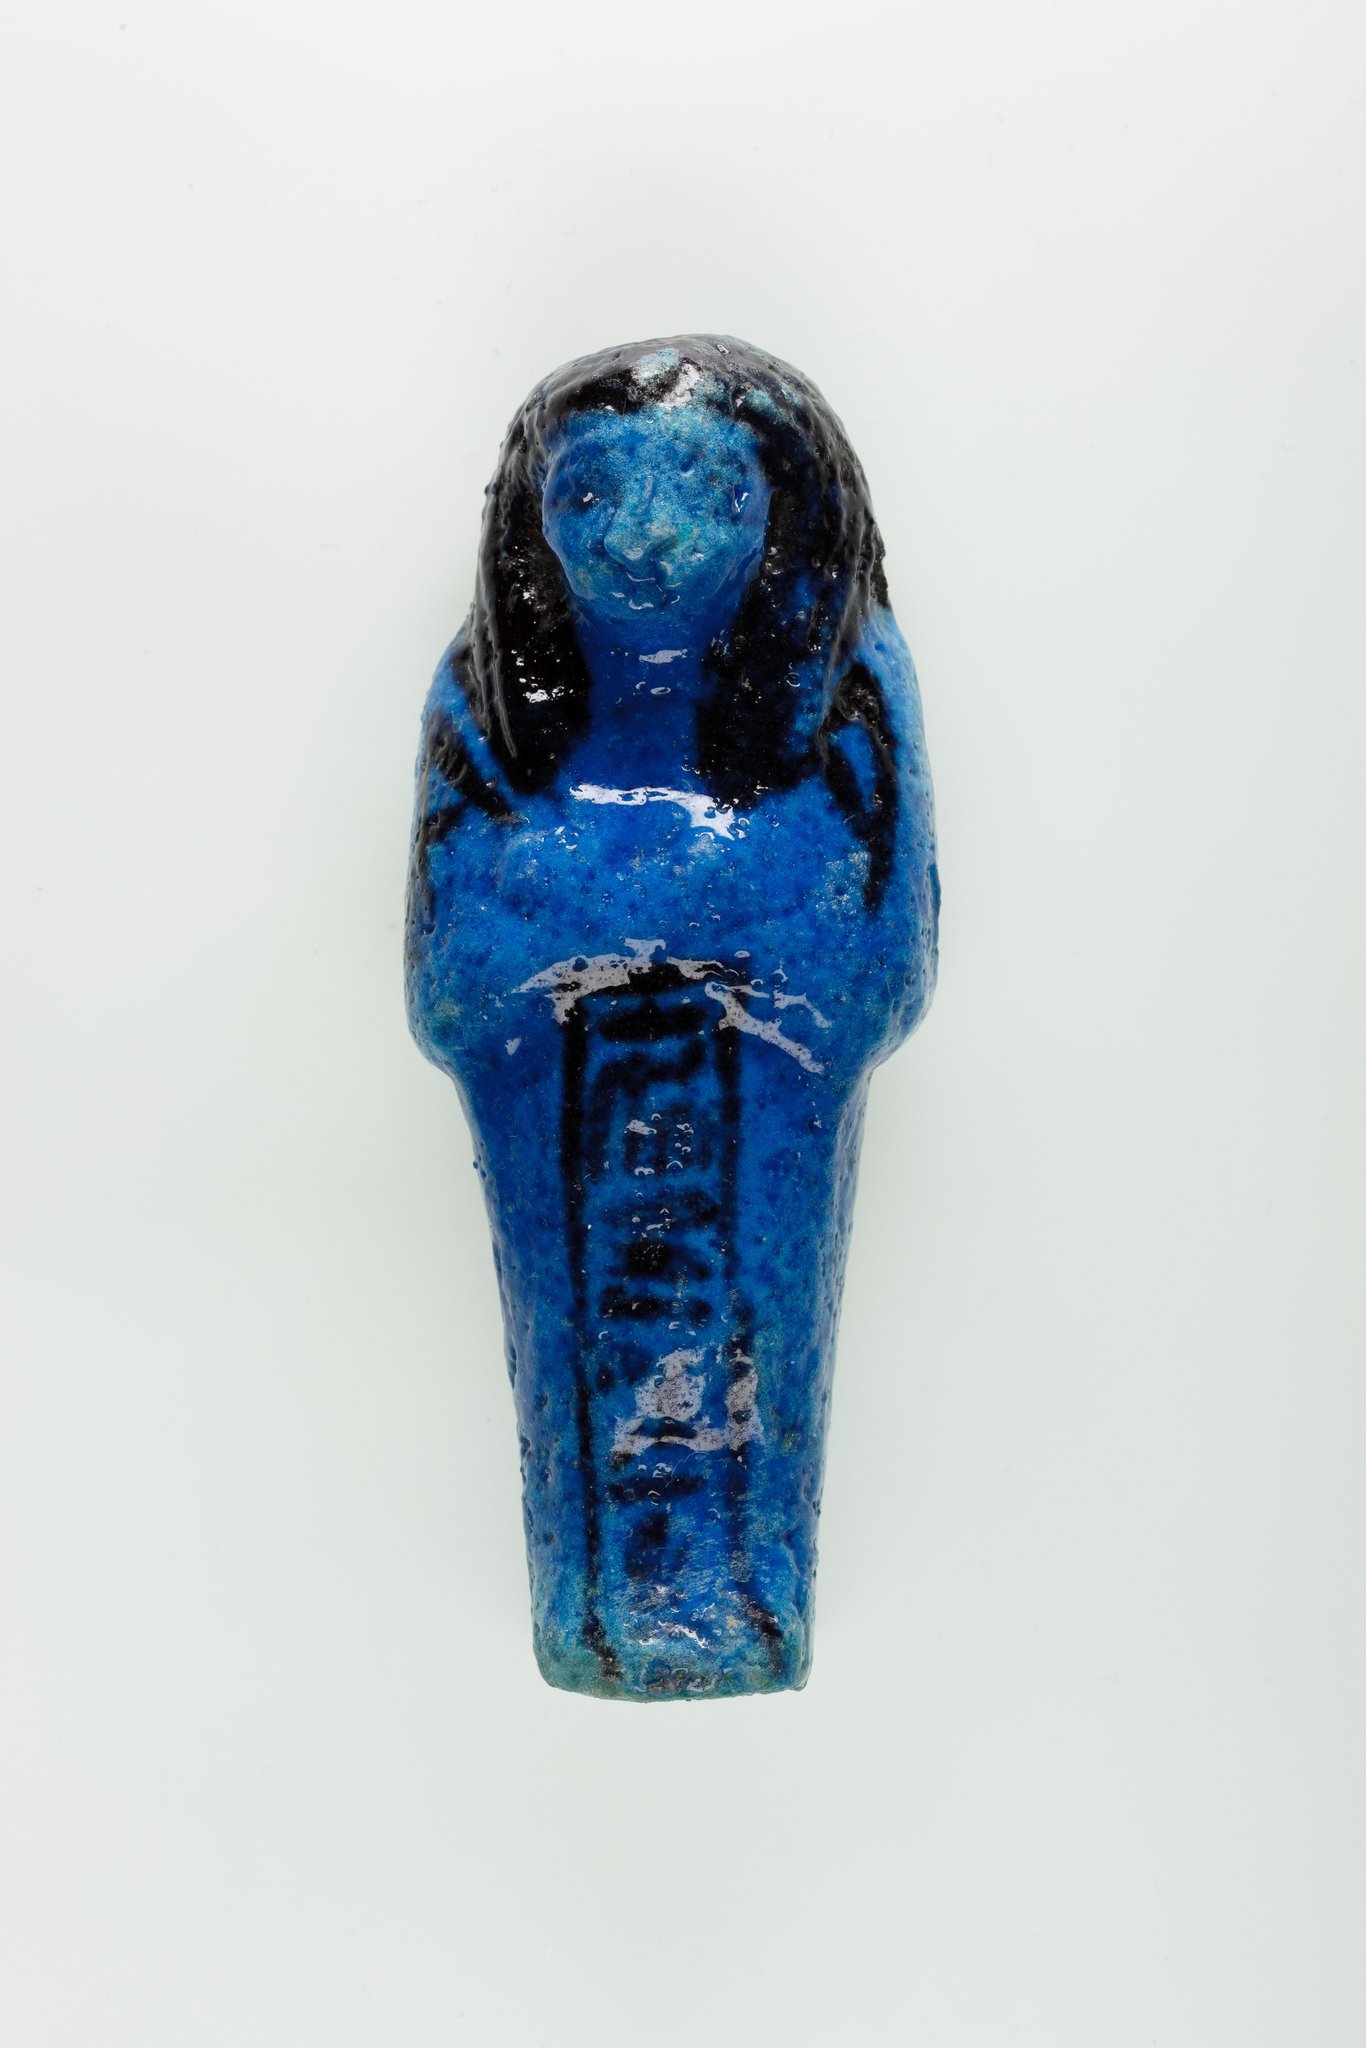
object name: shabti, worker, nauny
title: Worker Shabti of Nauny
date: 1050 BCE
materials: faience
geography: egypt